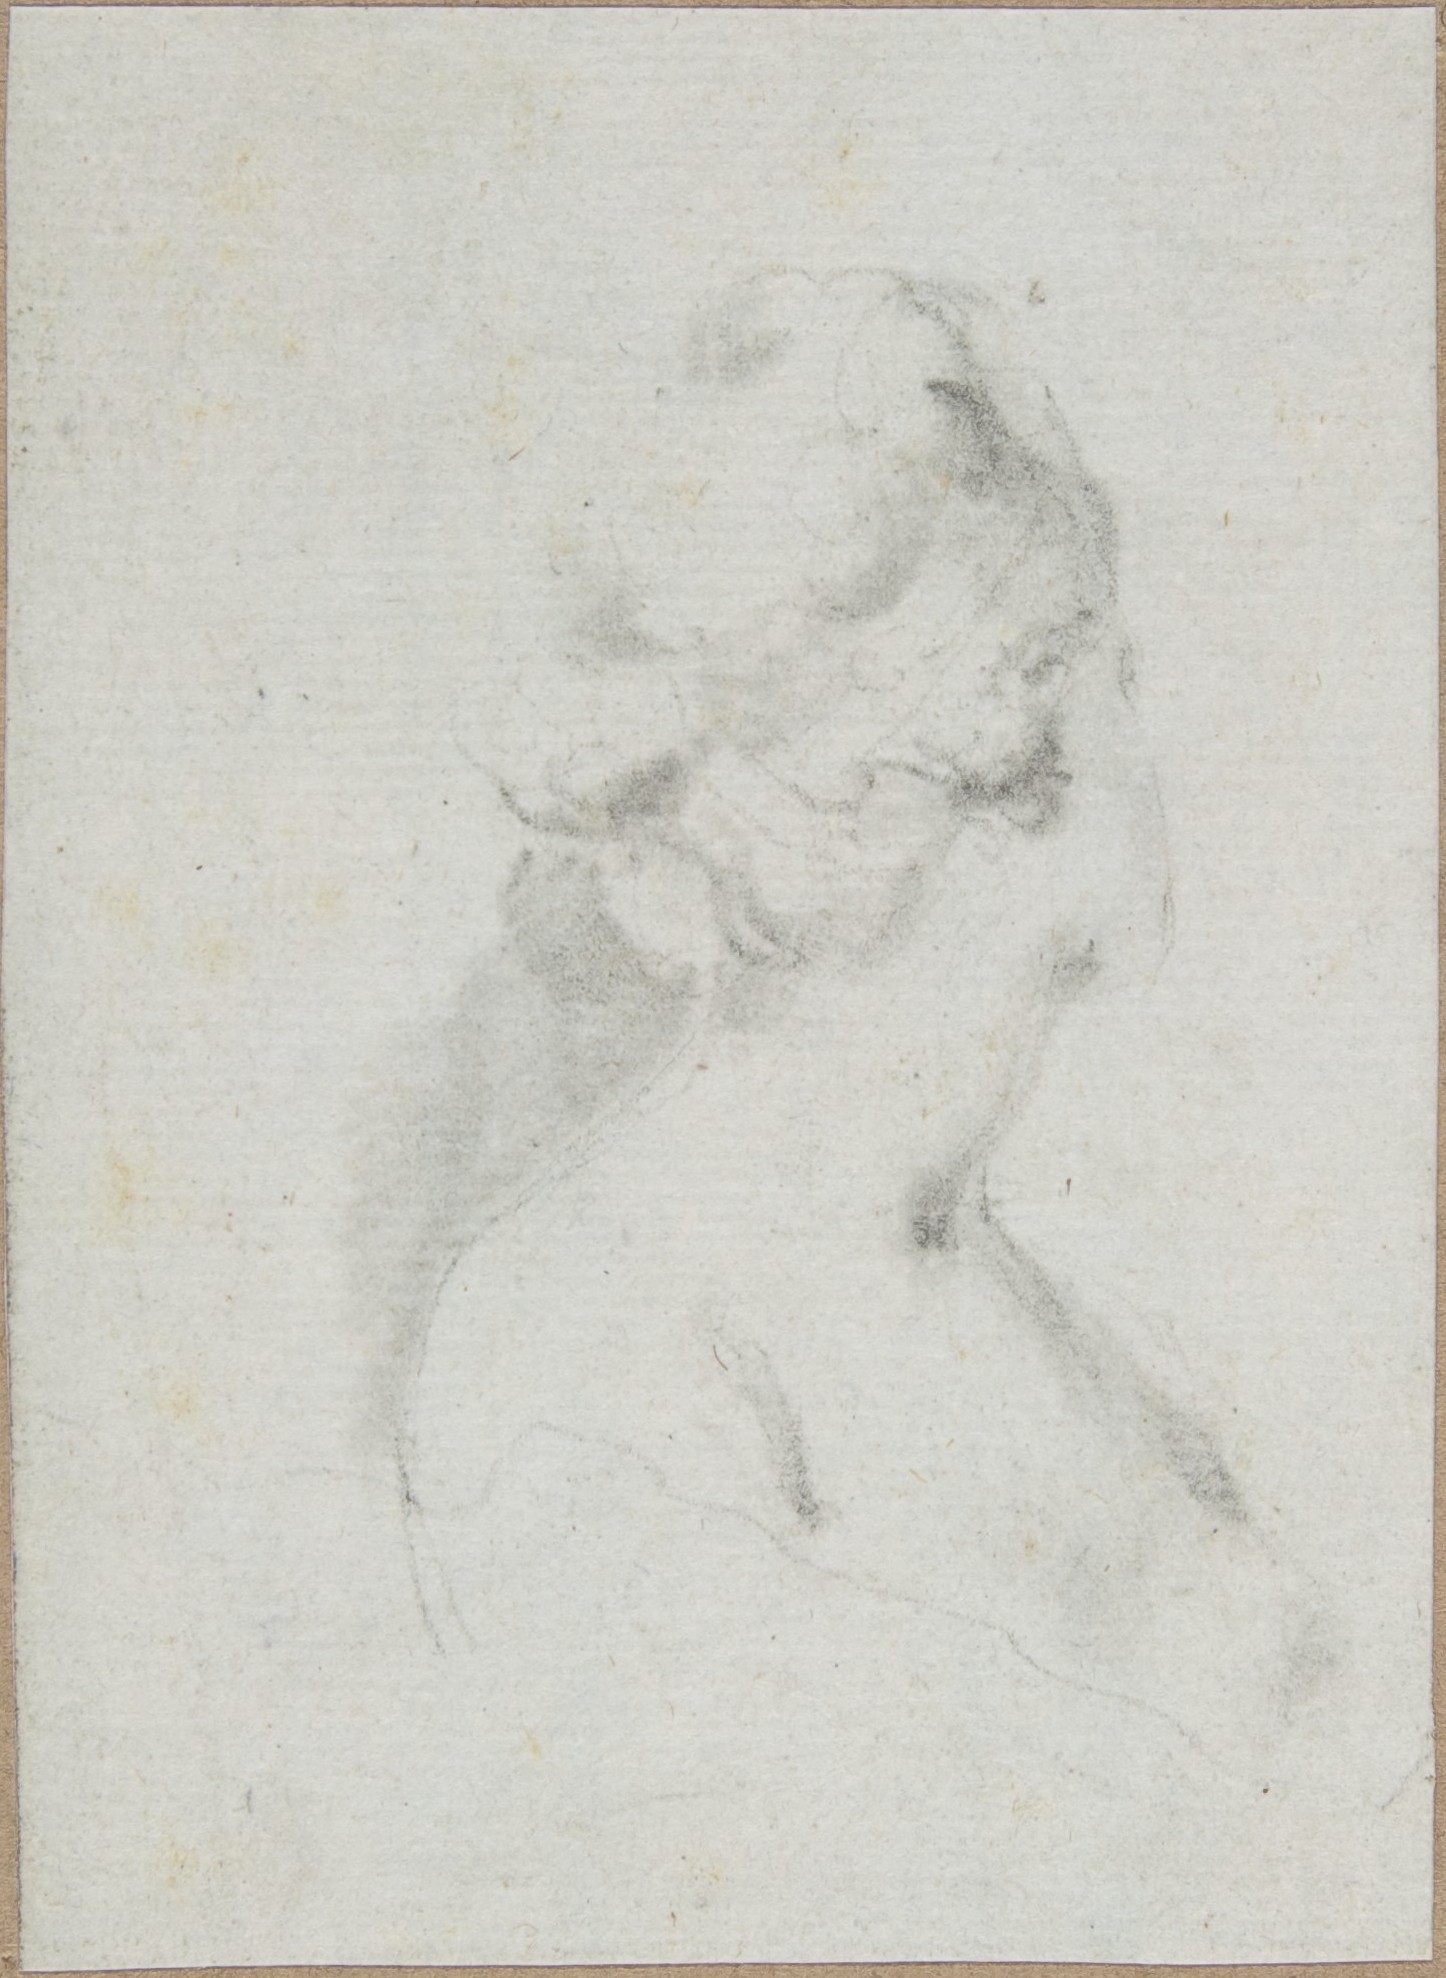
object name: drawing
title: Head and shoulders of a Woman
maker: baron dominique vivant denon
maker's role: artist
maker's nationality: french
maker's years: 1747-1825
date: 1794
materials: chalk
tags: heads,women